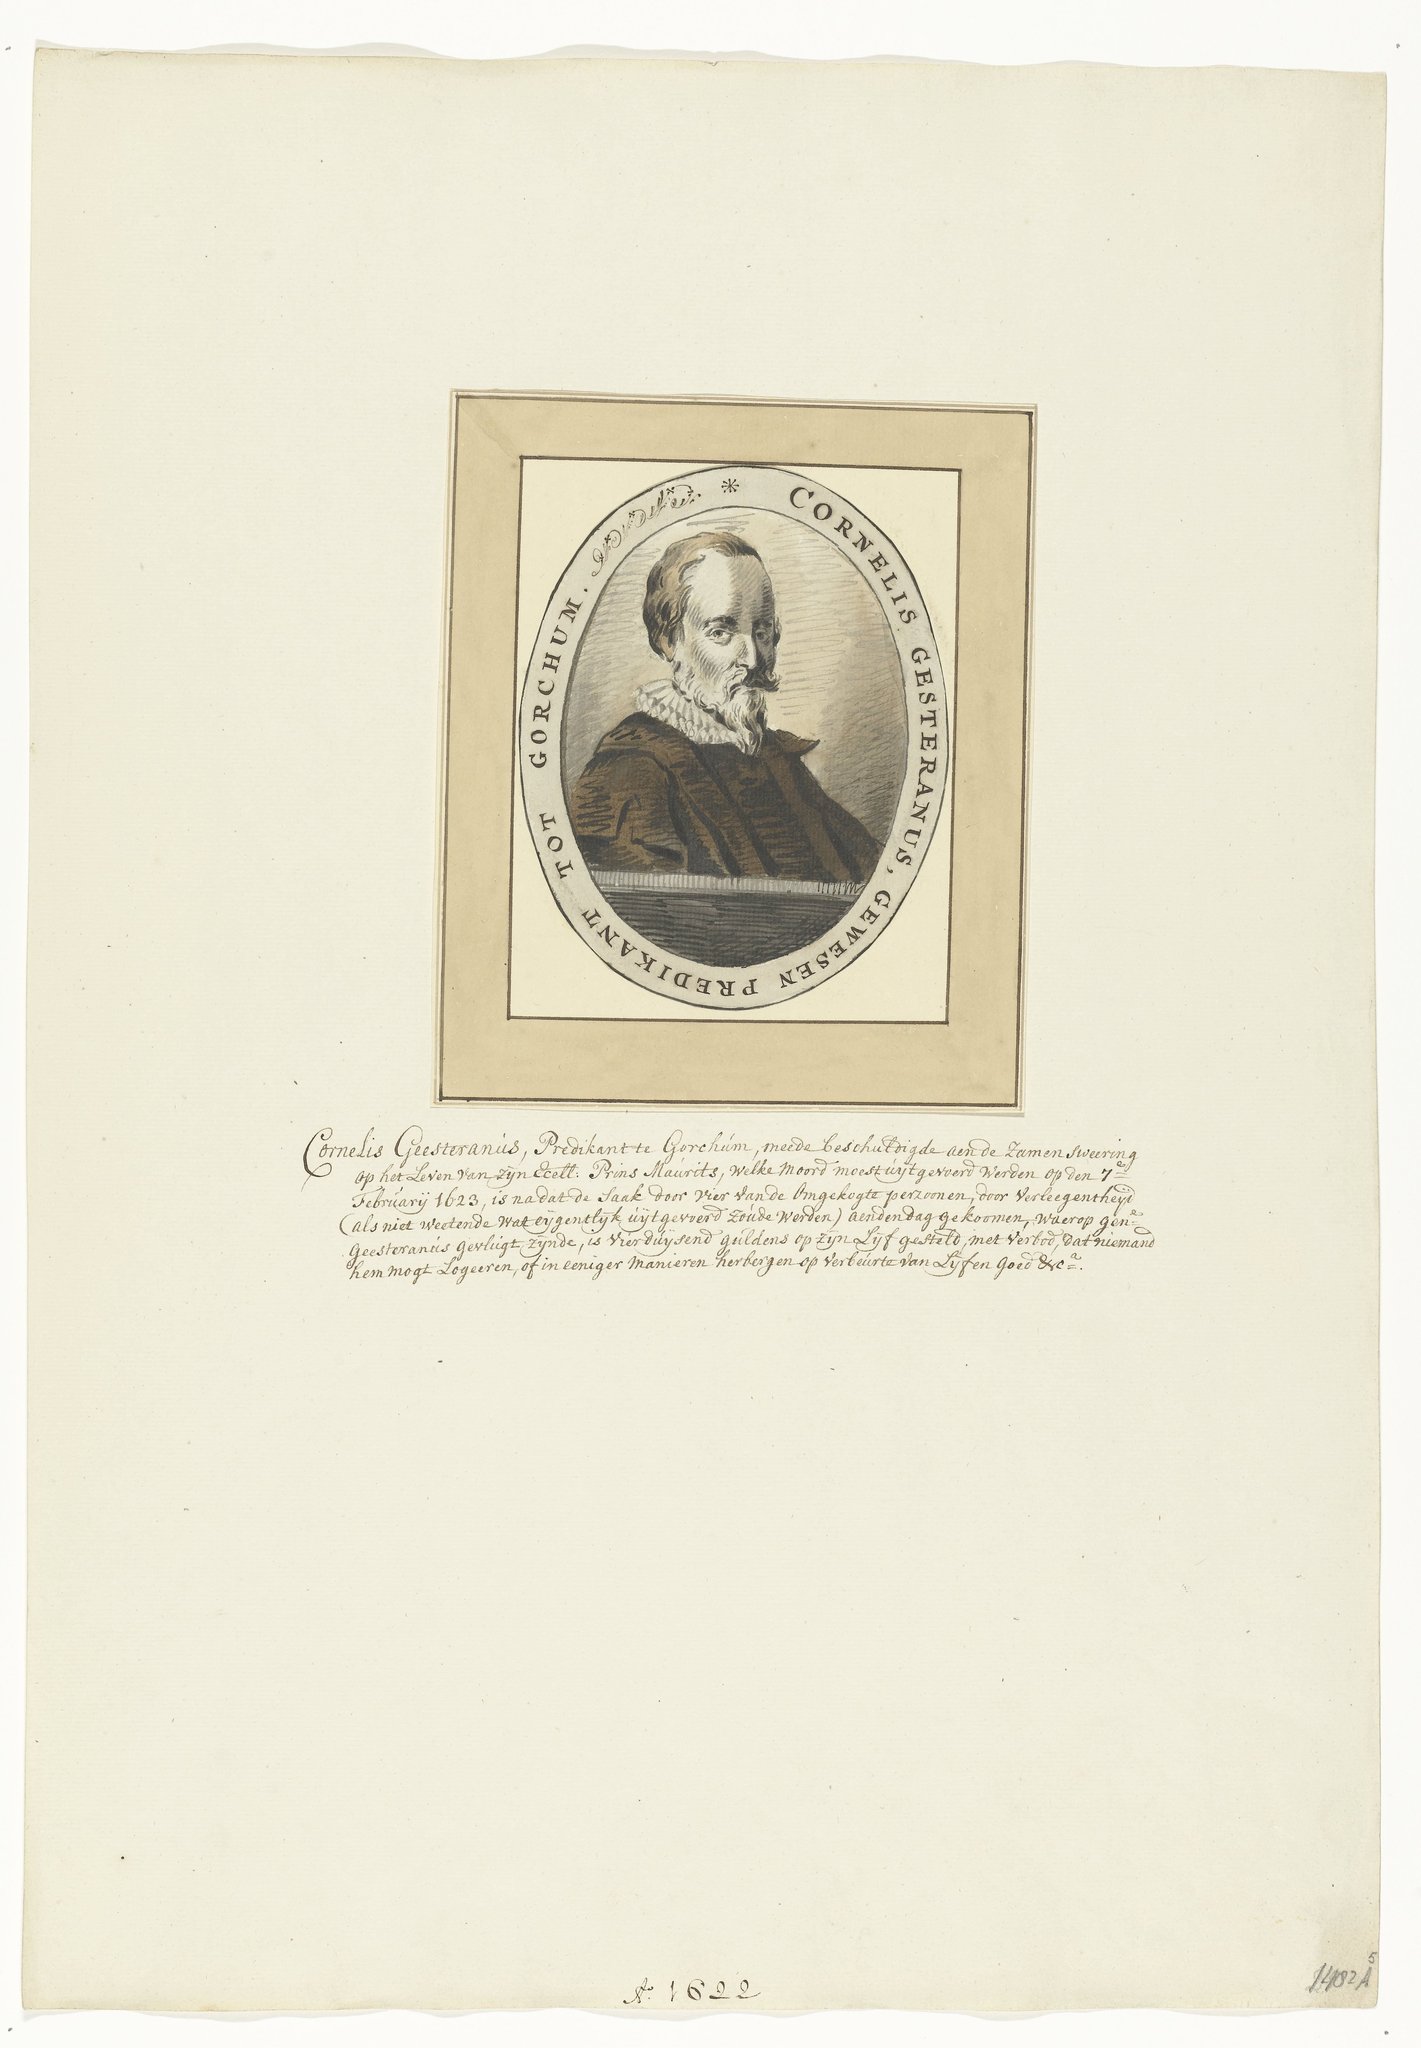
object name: historieplaat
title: Negen getekende portretten van de samenzweerders tegen Mauritis in 1623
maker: tako hajo jelgersma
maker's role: draughtsman, painter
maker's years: 1702-1795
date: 1715-1795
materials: paper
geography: netherlands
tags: hoorn (north holland), (revolutionary) plot, conspiracy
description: Portret van Cornelis Geesteranus, één van de samenzweerders tegen Maurits in 1623. Borstbeeld in ovaal, naar rechts. Met randschrift in het Nederlands. Op het blad onder het opgeplakte portret een handgeschreven levensbeschrijving van de afgebeelde persoon.